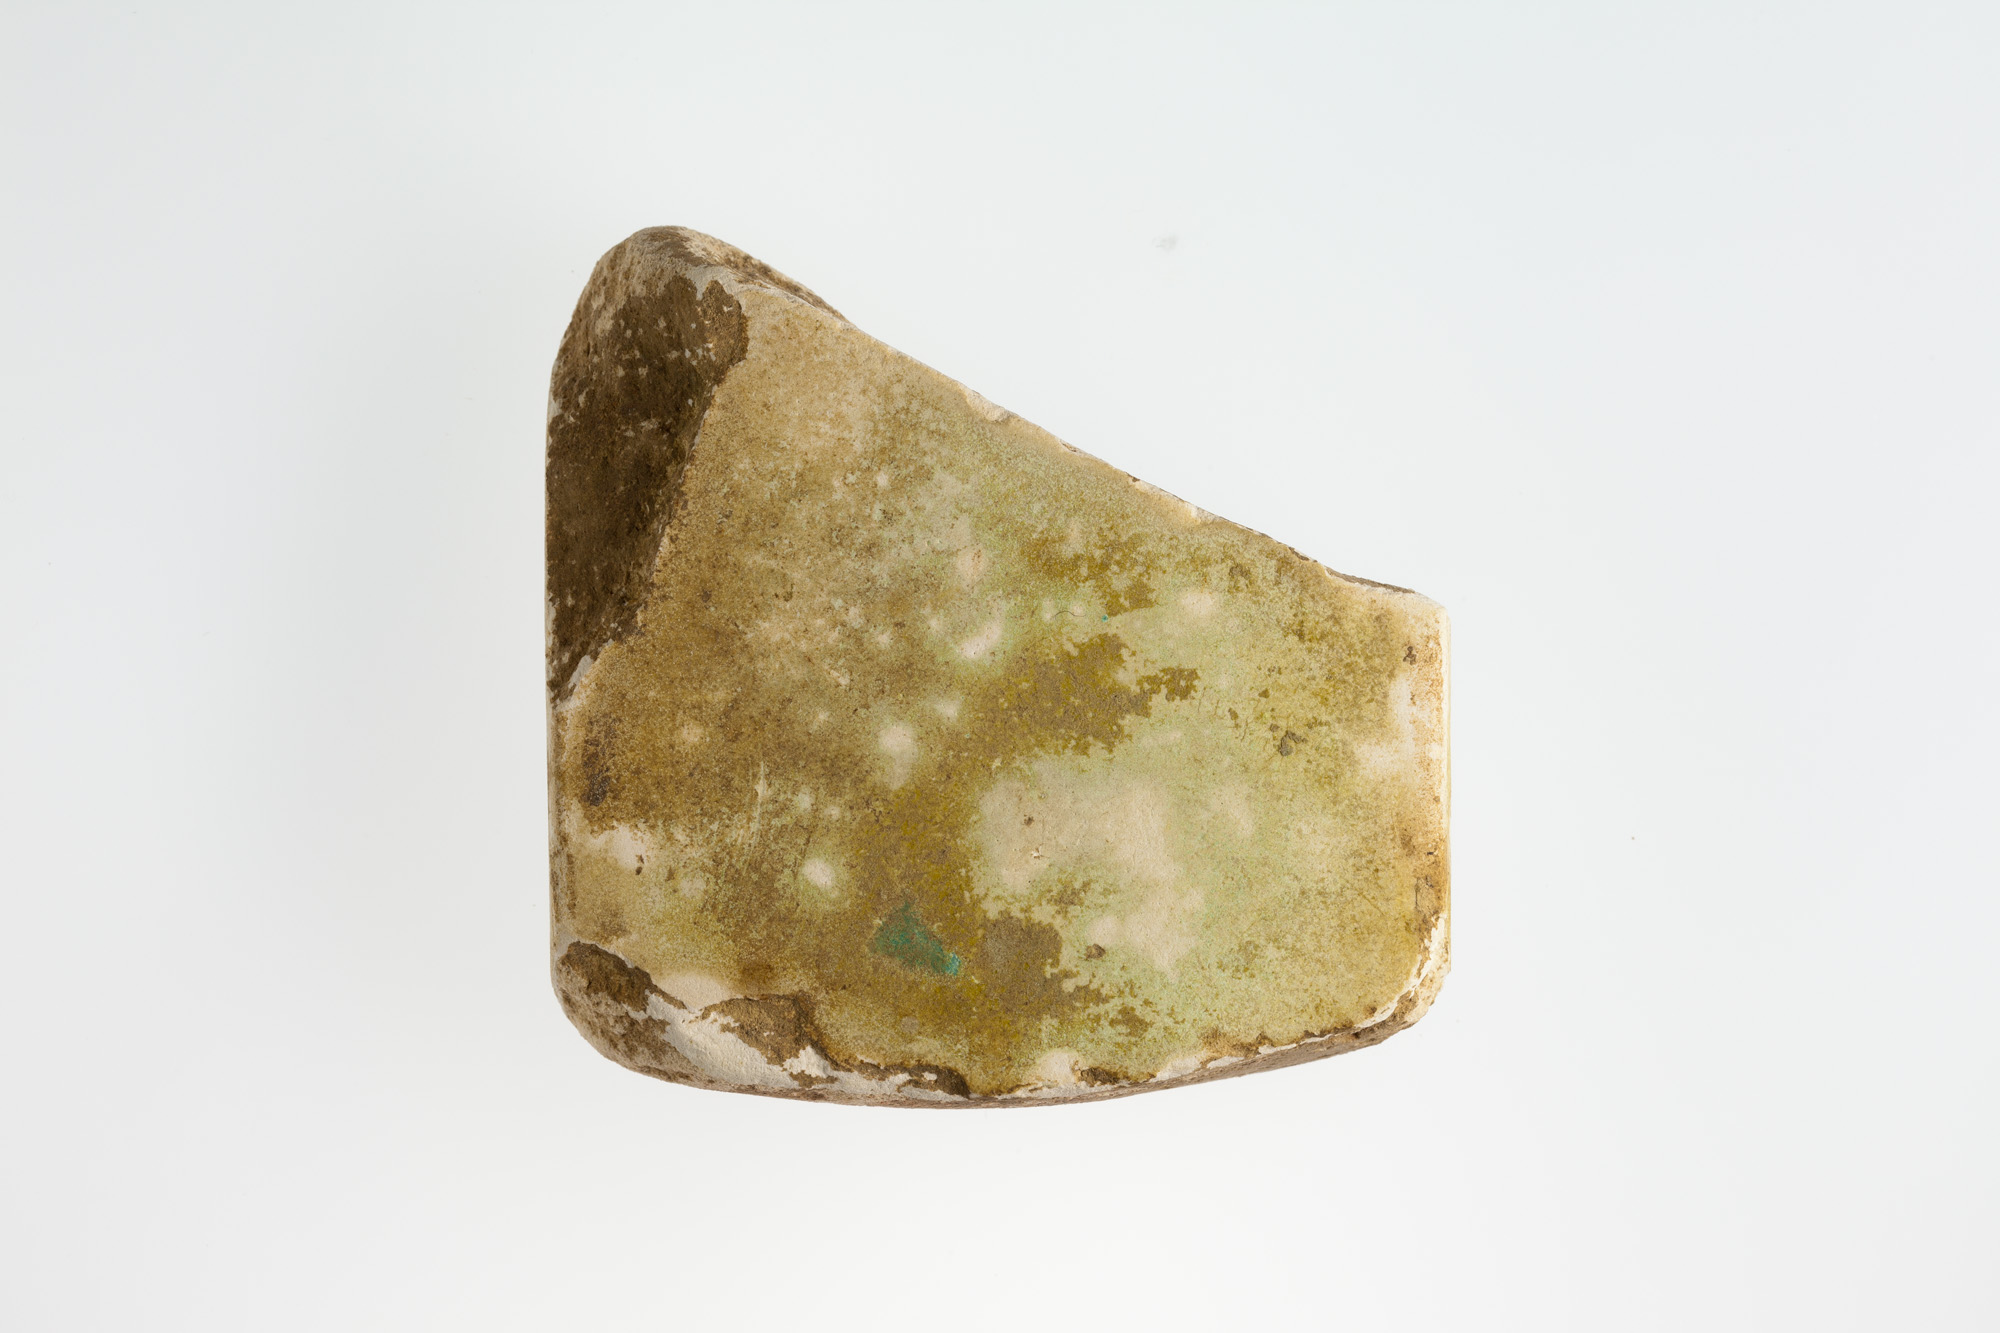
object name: tile fragment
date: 1981-1640 BCE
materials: faience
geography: egypt